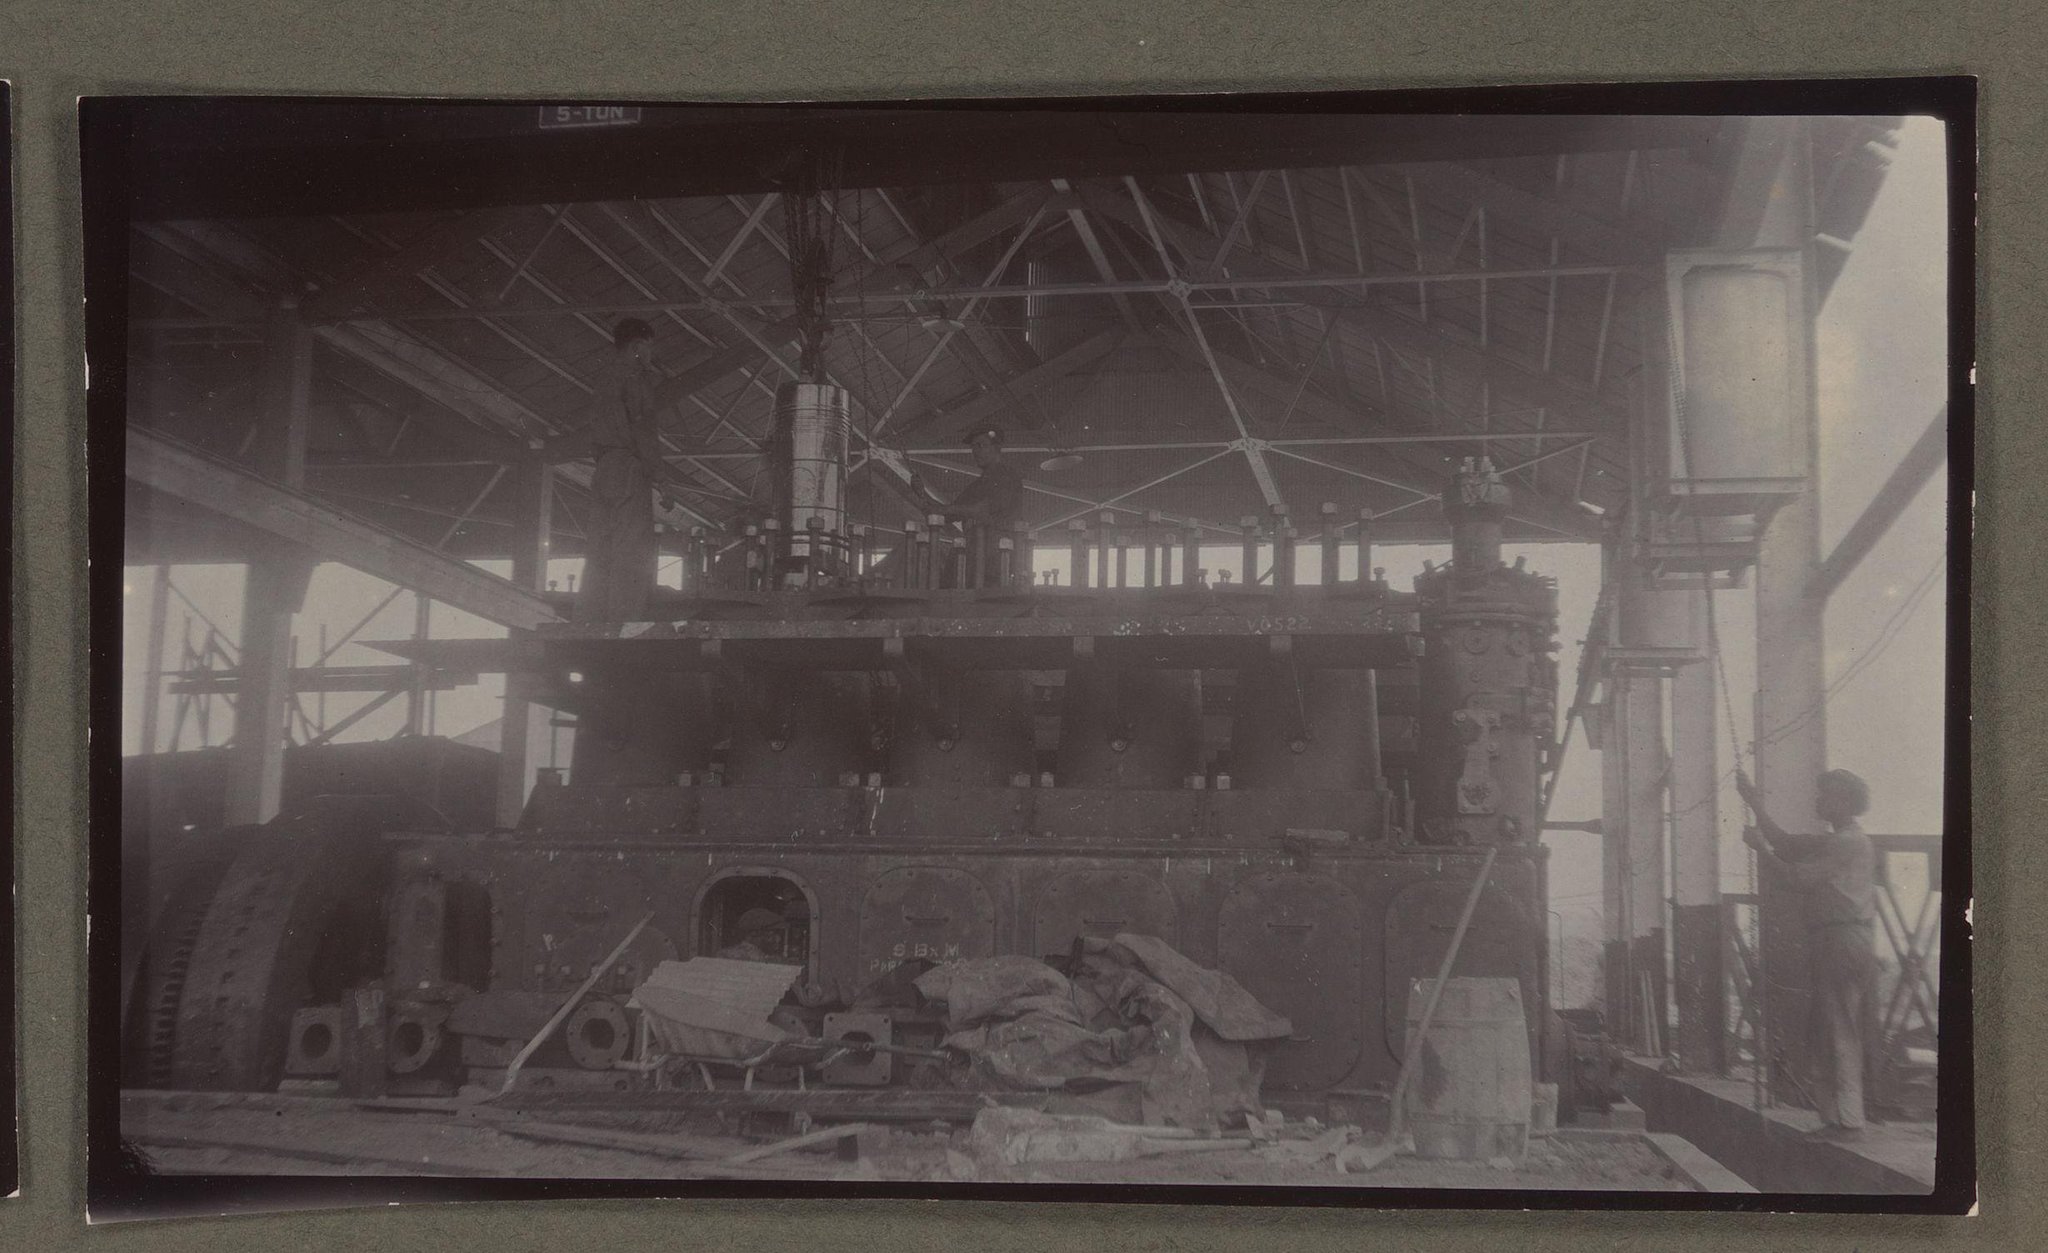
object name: photograph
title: Mijn en fabriek in Moengo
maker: Anonymous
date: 1925-1927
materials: photographic support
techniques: photography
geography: suriname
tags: jetten, familie, moengo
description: Mijn en fabriek in Moengo, interieur met machines. Foto op een bladzijde van een los albumblad. Onderdeel van het ensemble met foto's van de familie van ingenieur Jetten in de mijnbouwstad Moengo in Suriname.